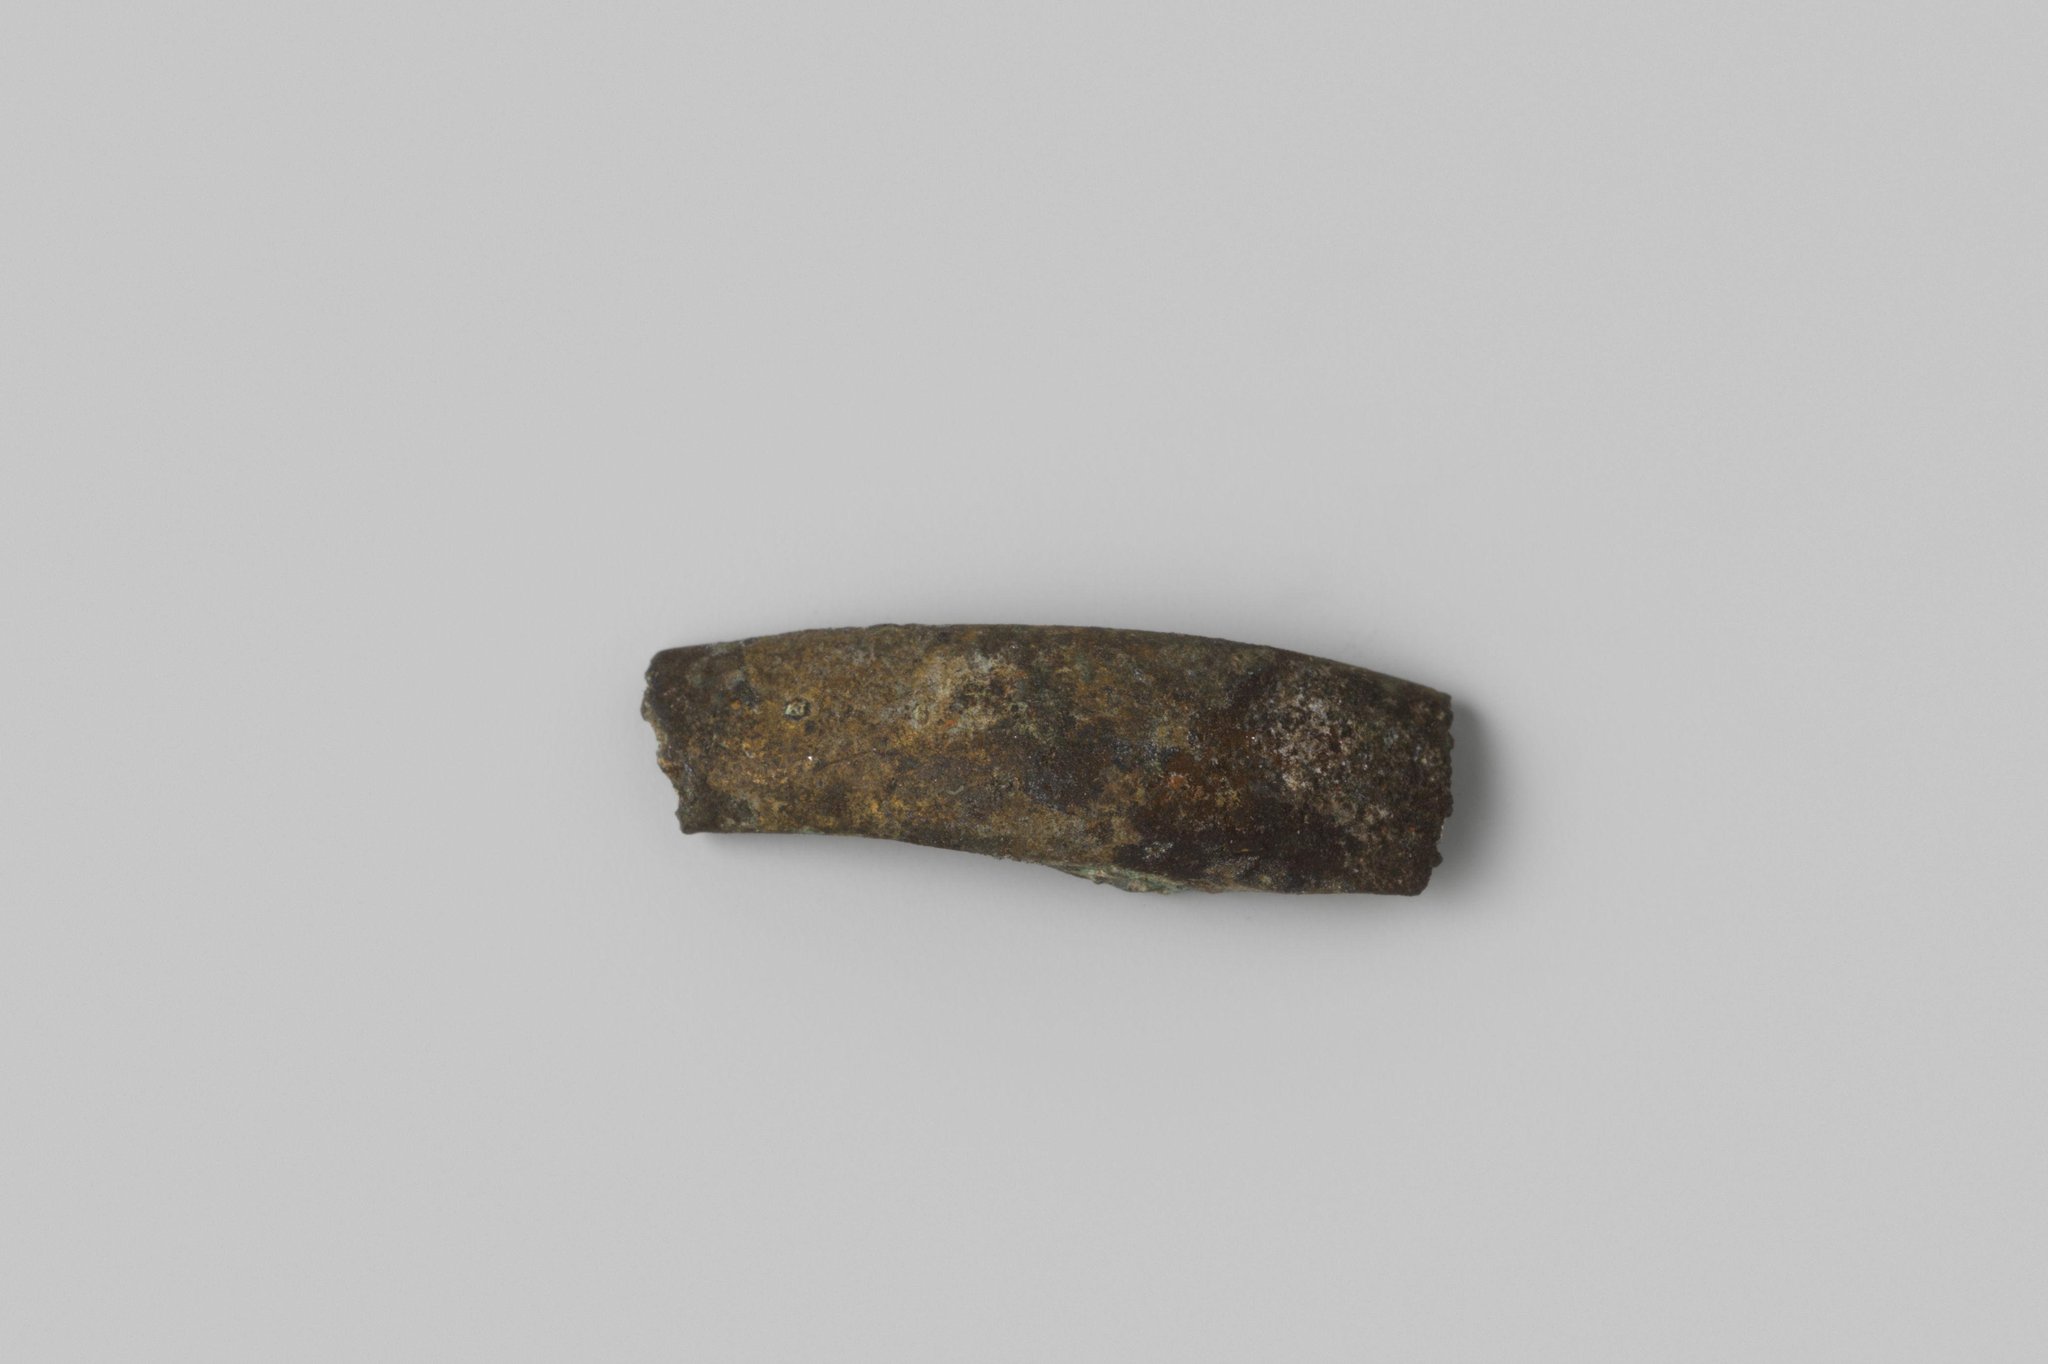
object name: shoe buckle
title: Fragment schoengesp uit het wrak van de Oost-Indiëvaarder Hollandia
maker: Anonymous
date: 1700-1743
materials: copper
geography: netherlands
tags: verenigde oostindische compagnie, hollandia (schip), annet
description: Buckle, chape buckle, shoe buckle; fragment of ring with spindle eye, plain.